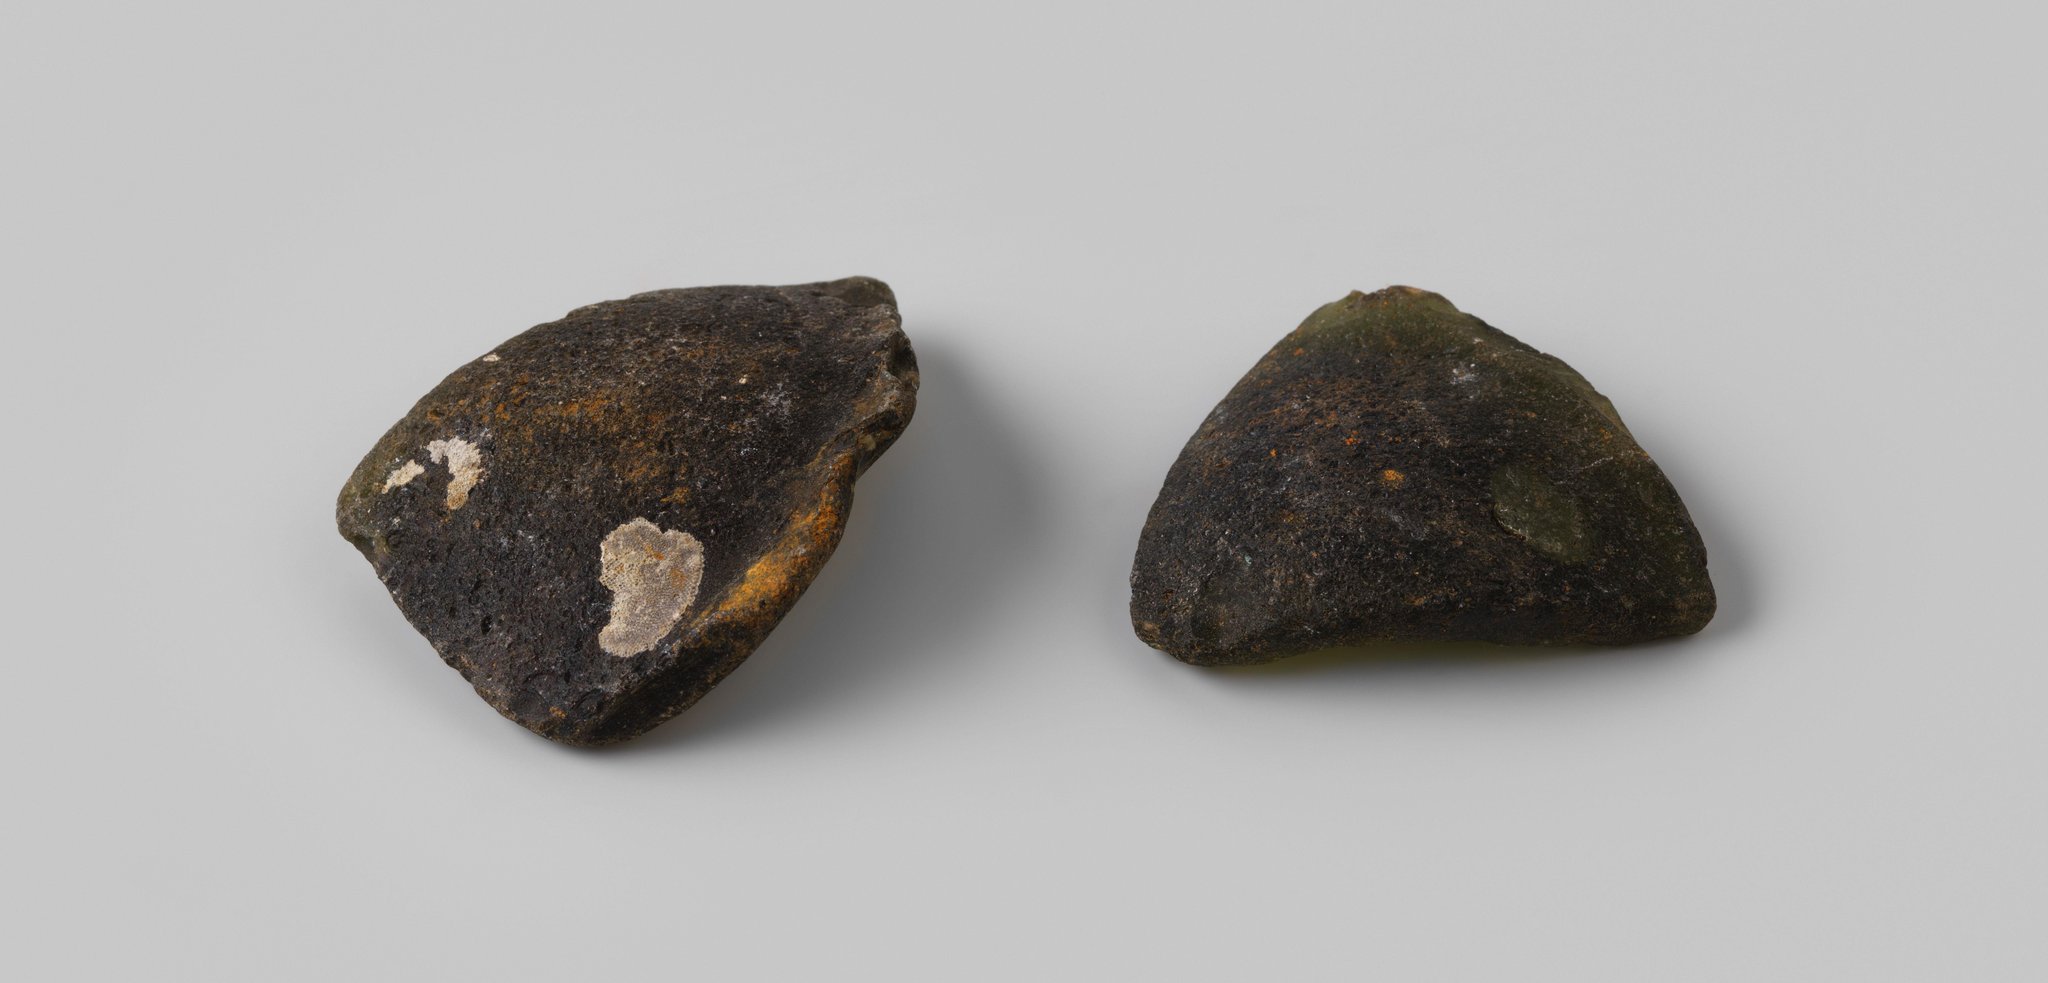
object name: sherd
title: Scherven van wijnflessen uit het wrak van de Oost-Indiëvaarder Hollandia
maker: Anonymous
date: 1700-1743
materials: glass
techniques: green glass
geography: netherlands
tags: verenigde oostindische compagnie, hollandia (schip), annet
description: Typologically not identifiable, base, fragm.